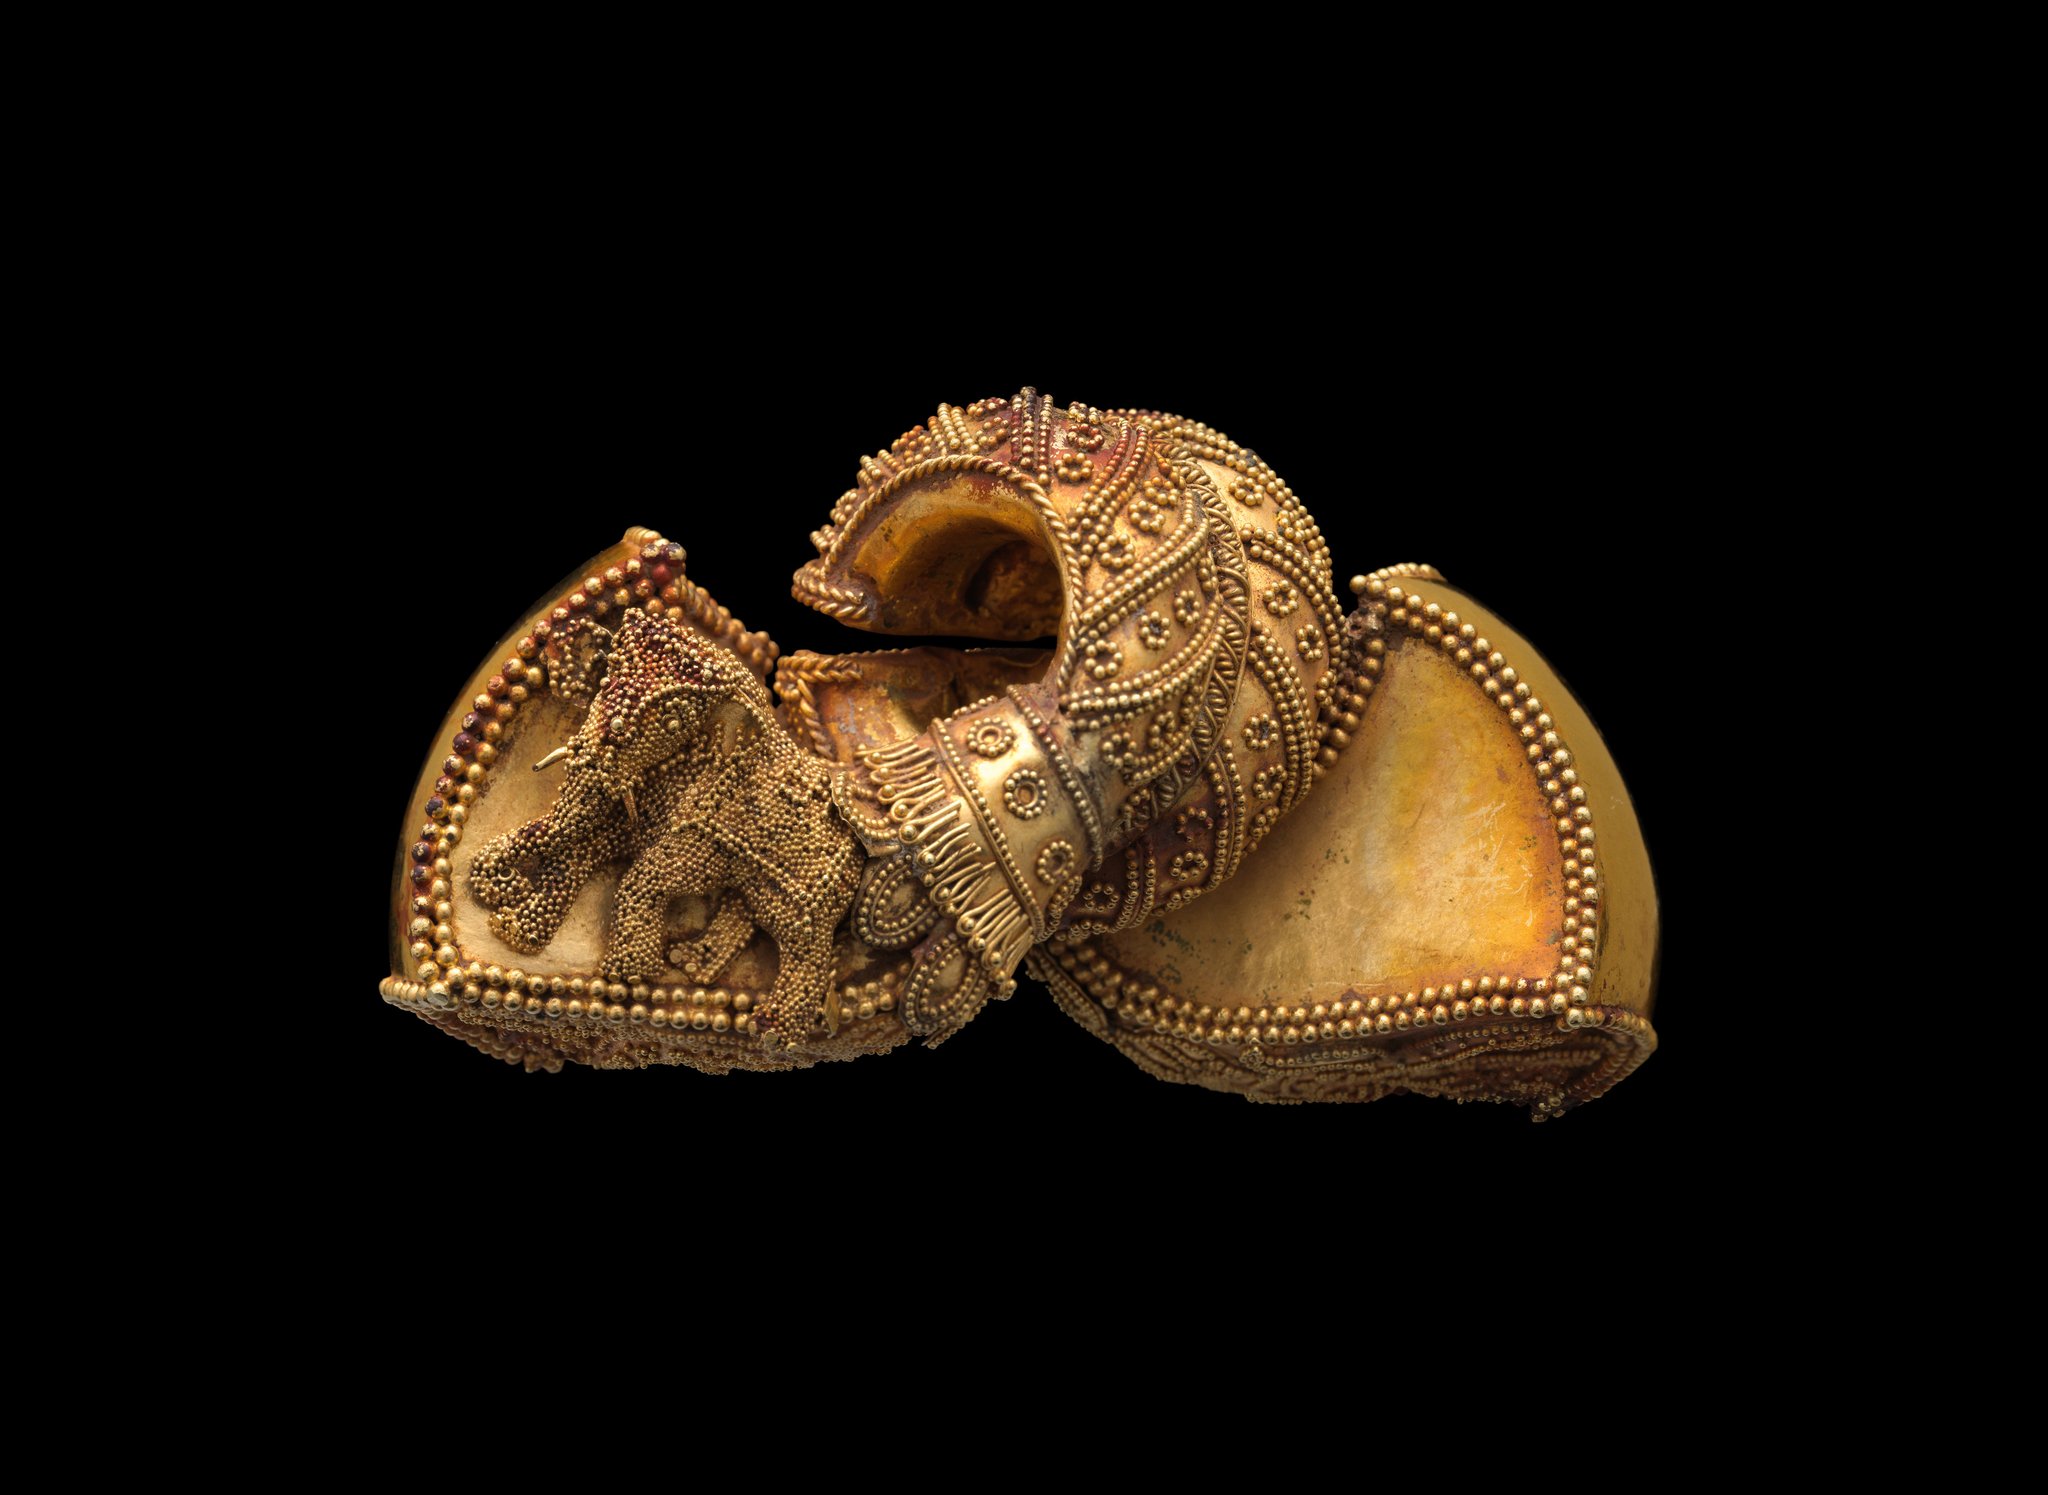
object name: earring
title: One from a Pair of Ear Ornaments (Prakaravapra Kundala)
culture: indian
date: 1-100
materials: gold, metal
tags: satavahana,elephants,lions